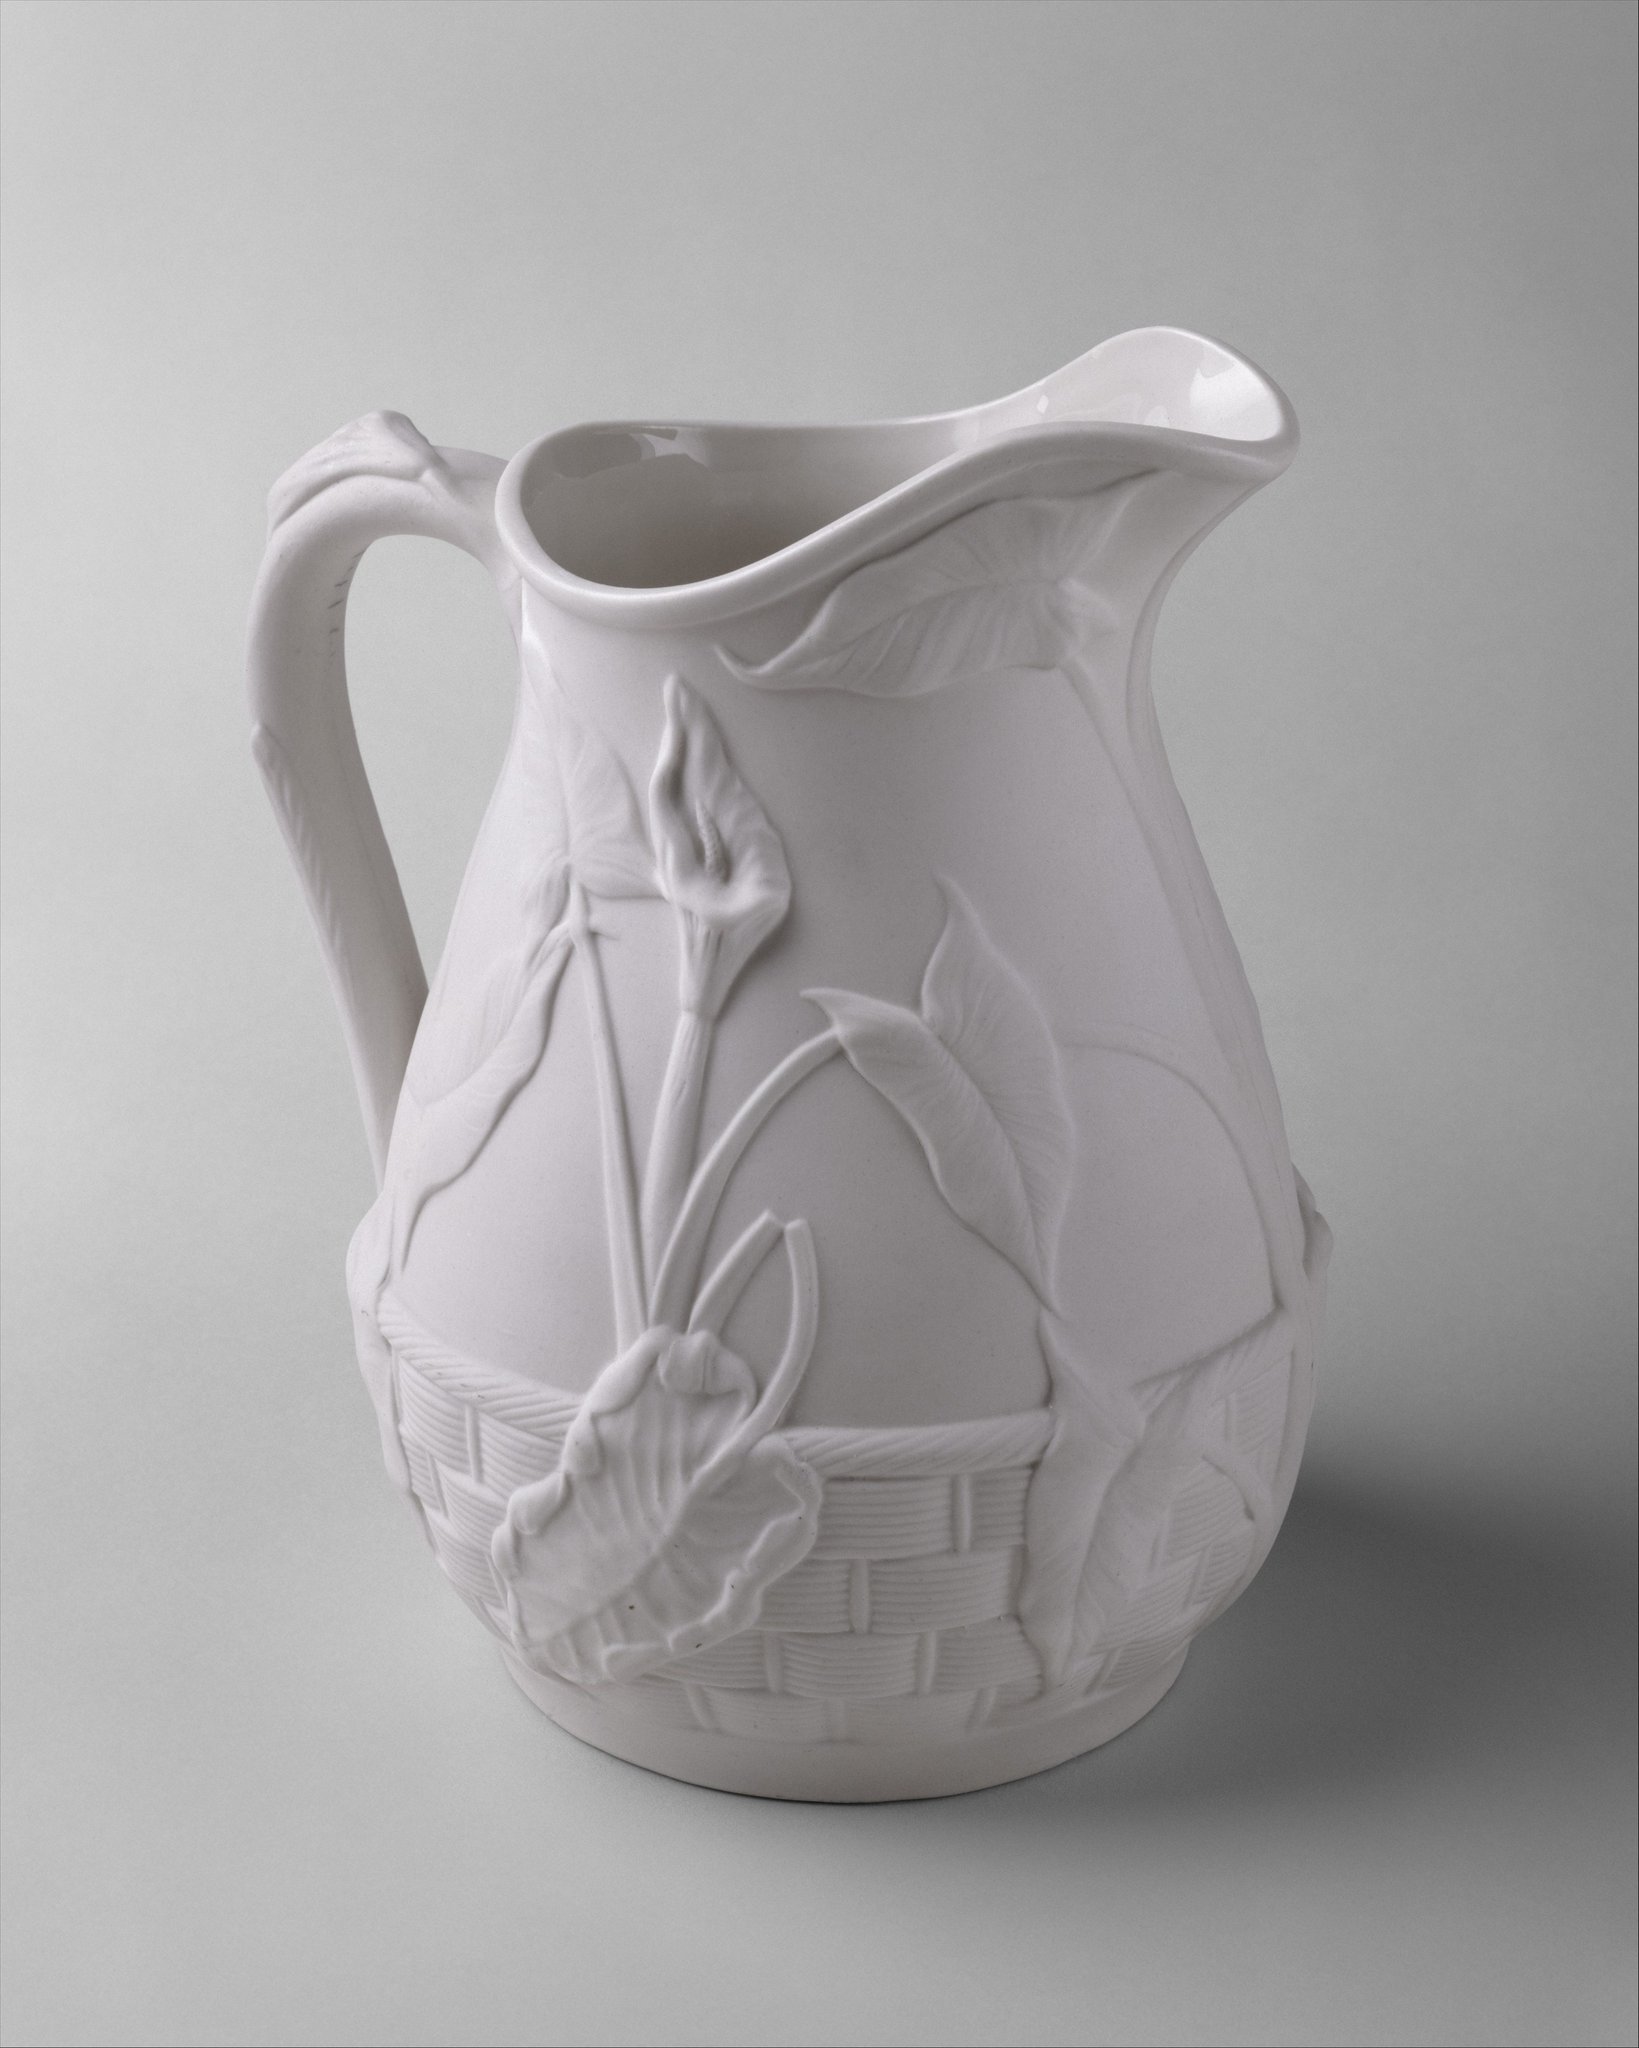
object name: pitcher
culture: american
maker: dallas pottery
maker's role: manufacturer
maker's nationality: american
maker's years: 1865-1882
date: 1875-1879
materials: porcelain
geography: united states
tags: flowers